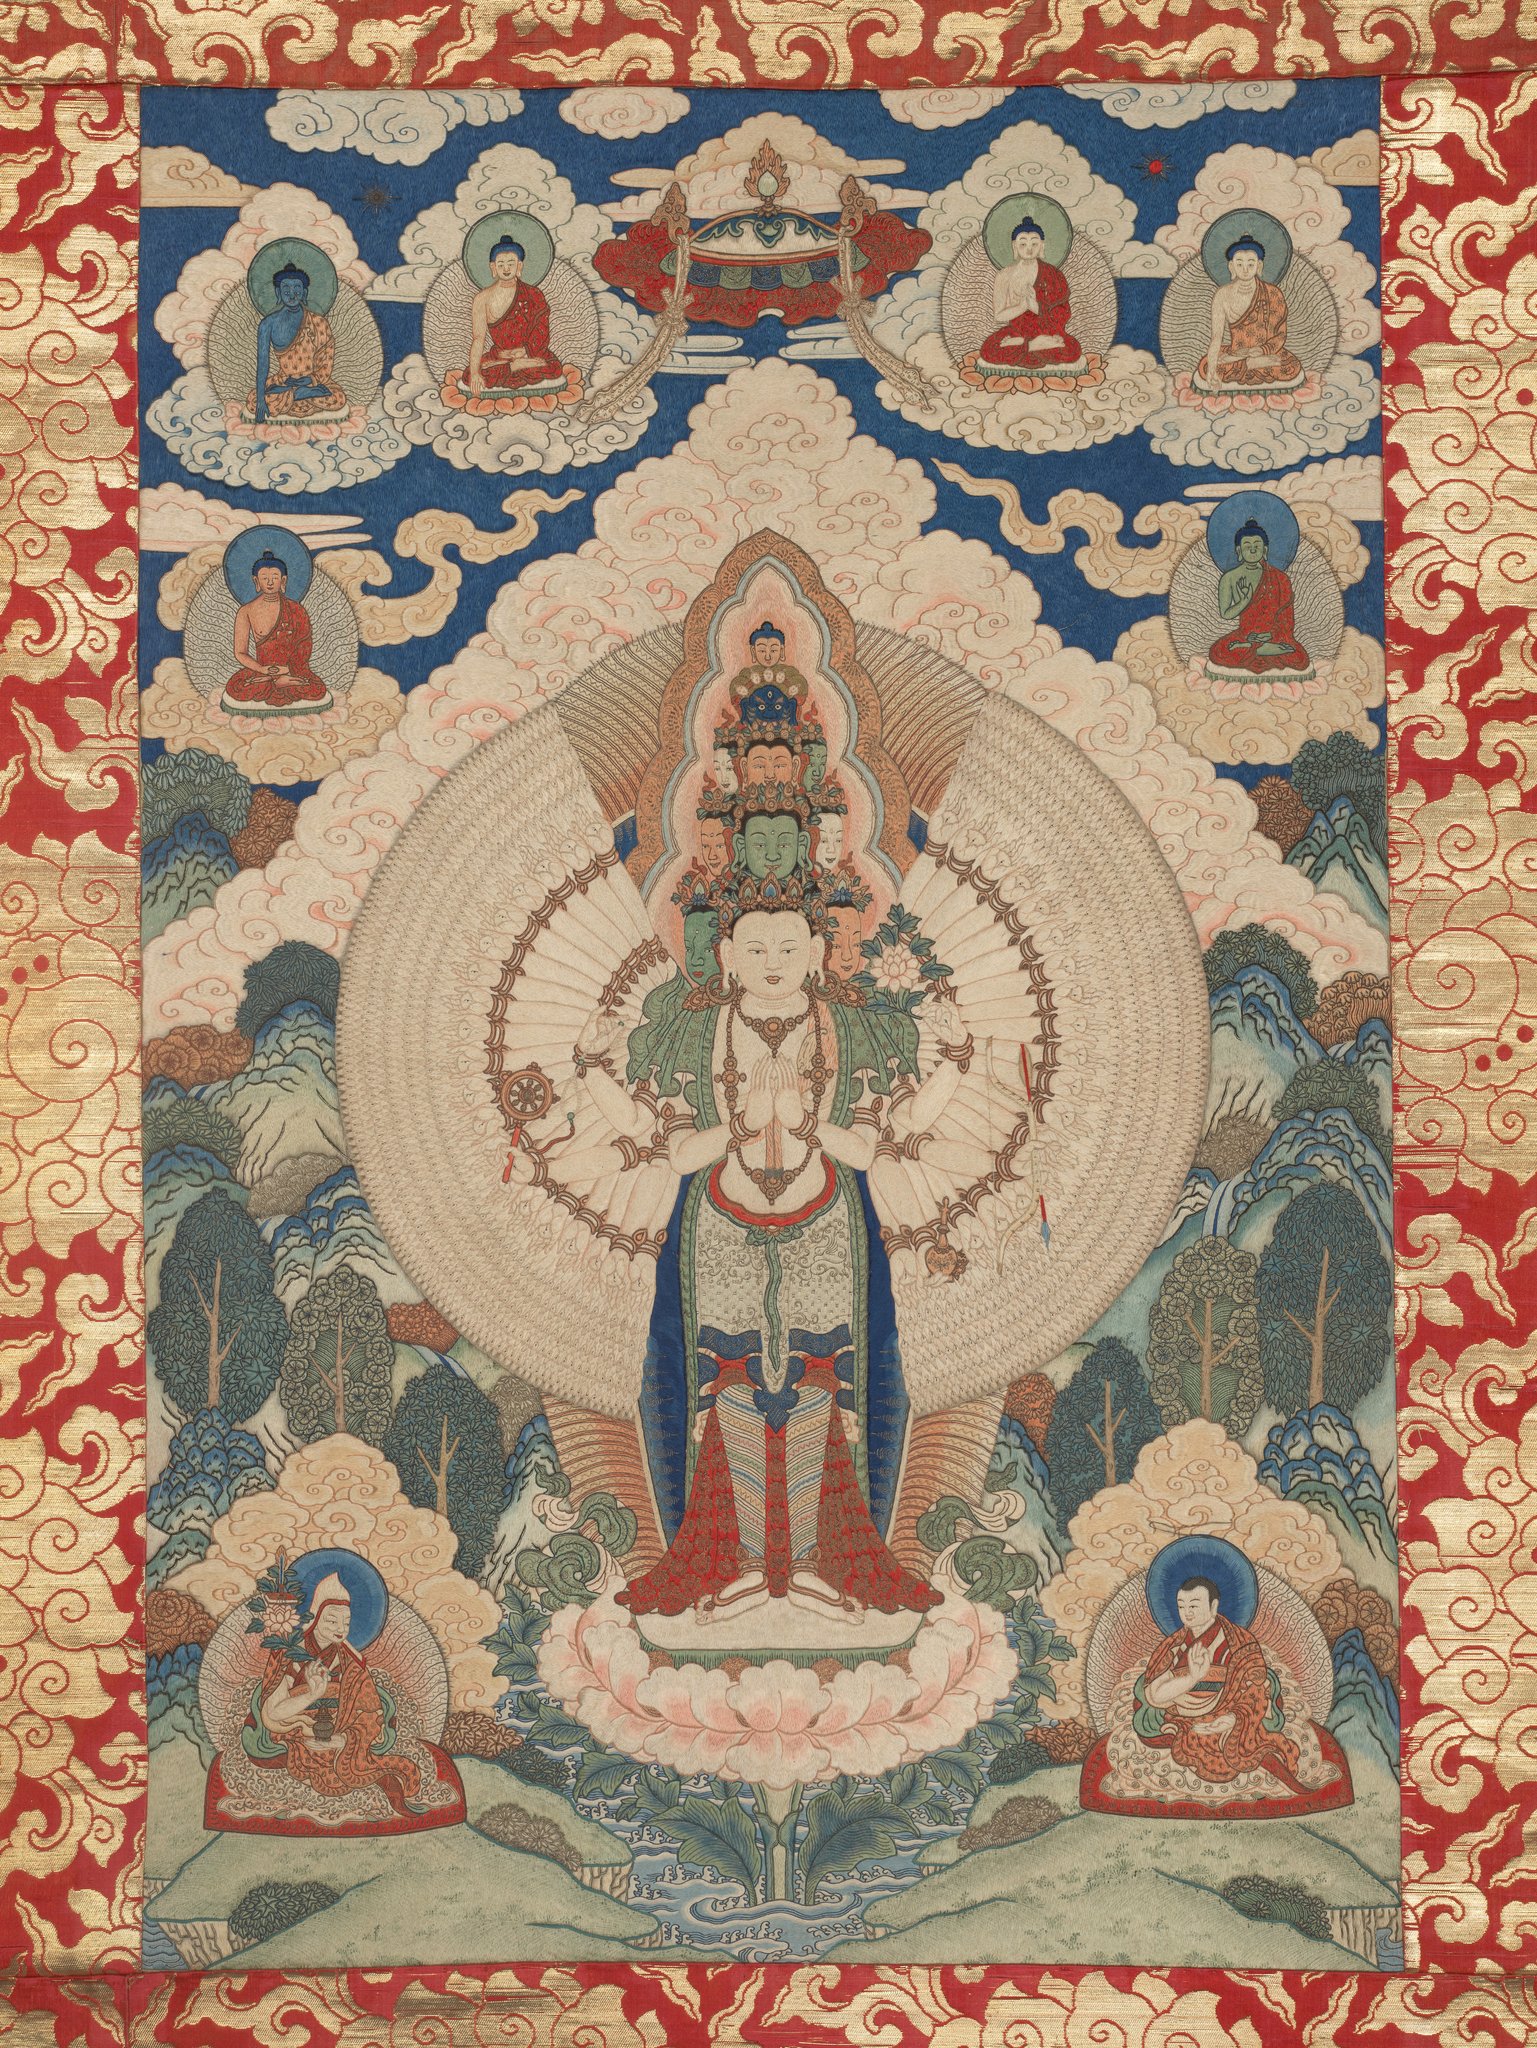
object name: temple banner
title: Eleven-headed bodhisattva Guanyin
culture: chinese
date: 1778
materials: metal thread, silk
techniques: embroidery, weave